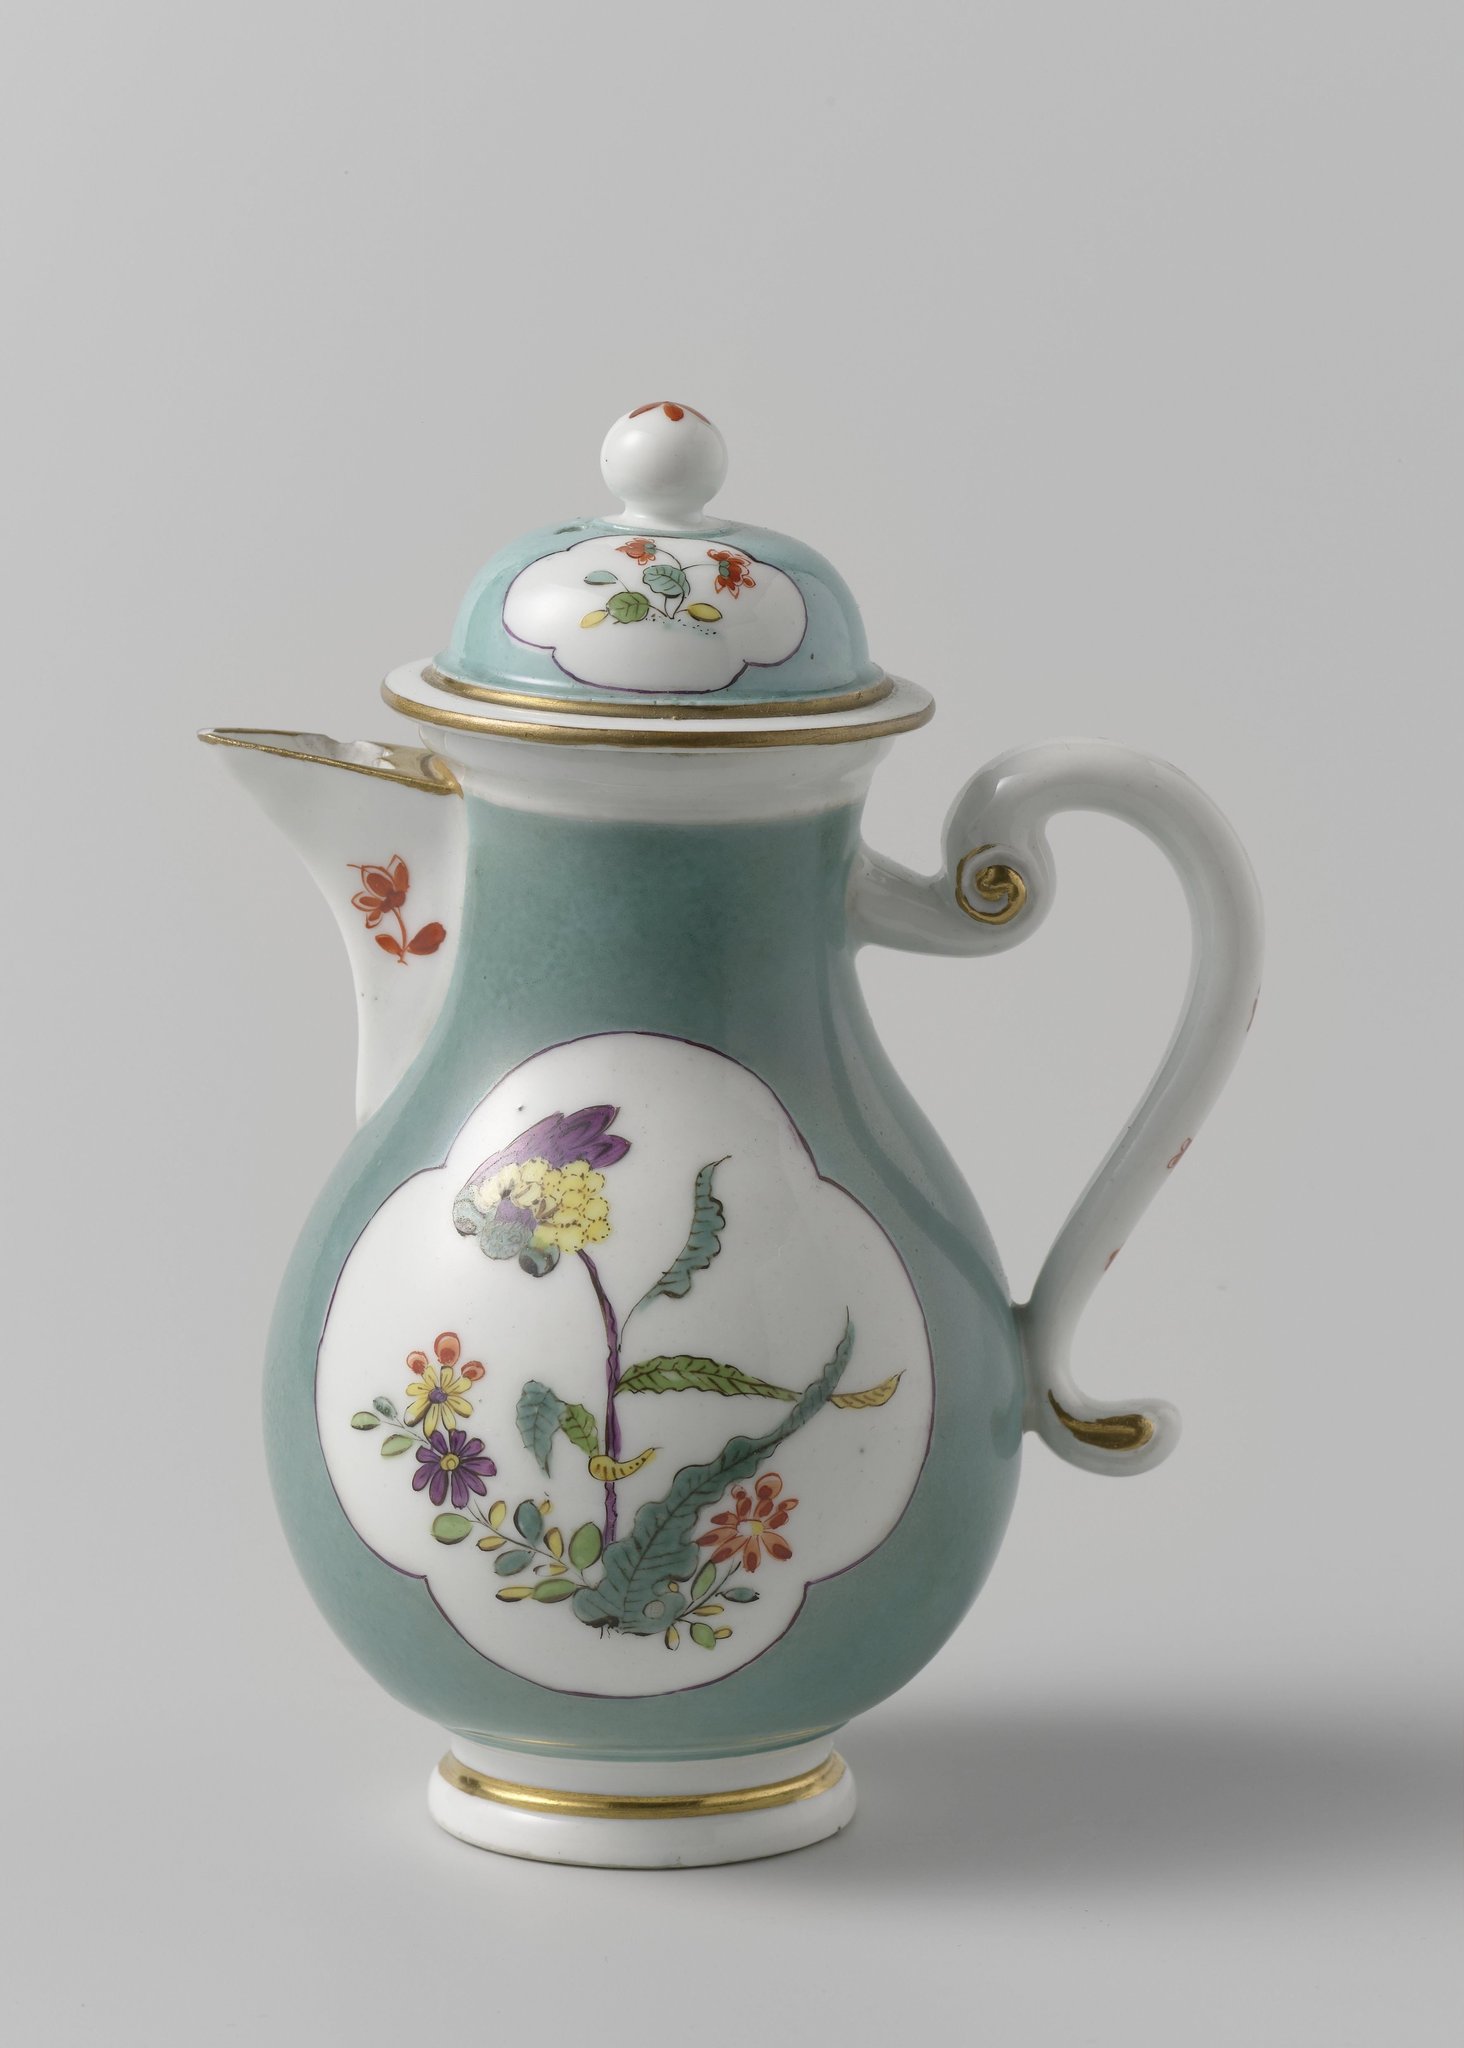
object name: eating drinking utensil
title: Melkkan, veelkleurig beschilderd met bloemtakken op een zeegroene fond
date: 1737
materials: porcelain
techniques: painted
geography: meissen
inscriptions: factory mark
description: Two jugs. Porcelain. Meissen, c. 1725 - 1730. Given by L. Mainz, 1938.